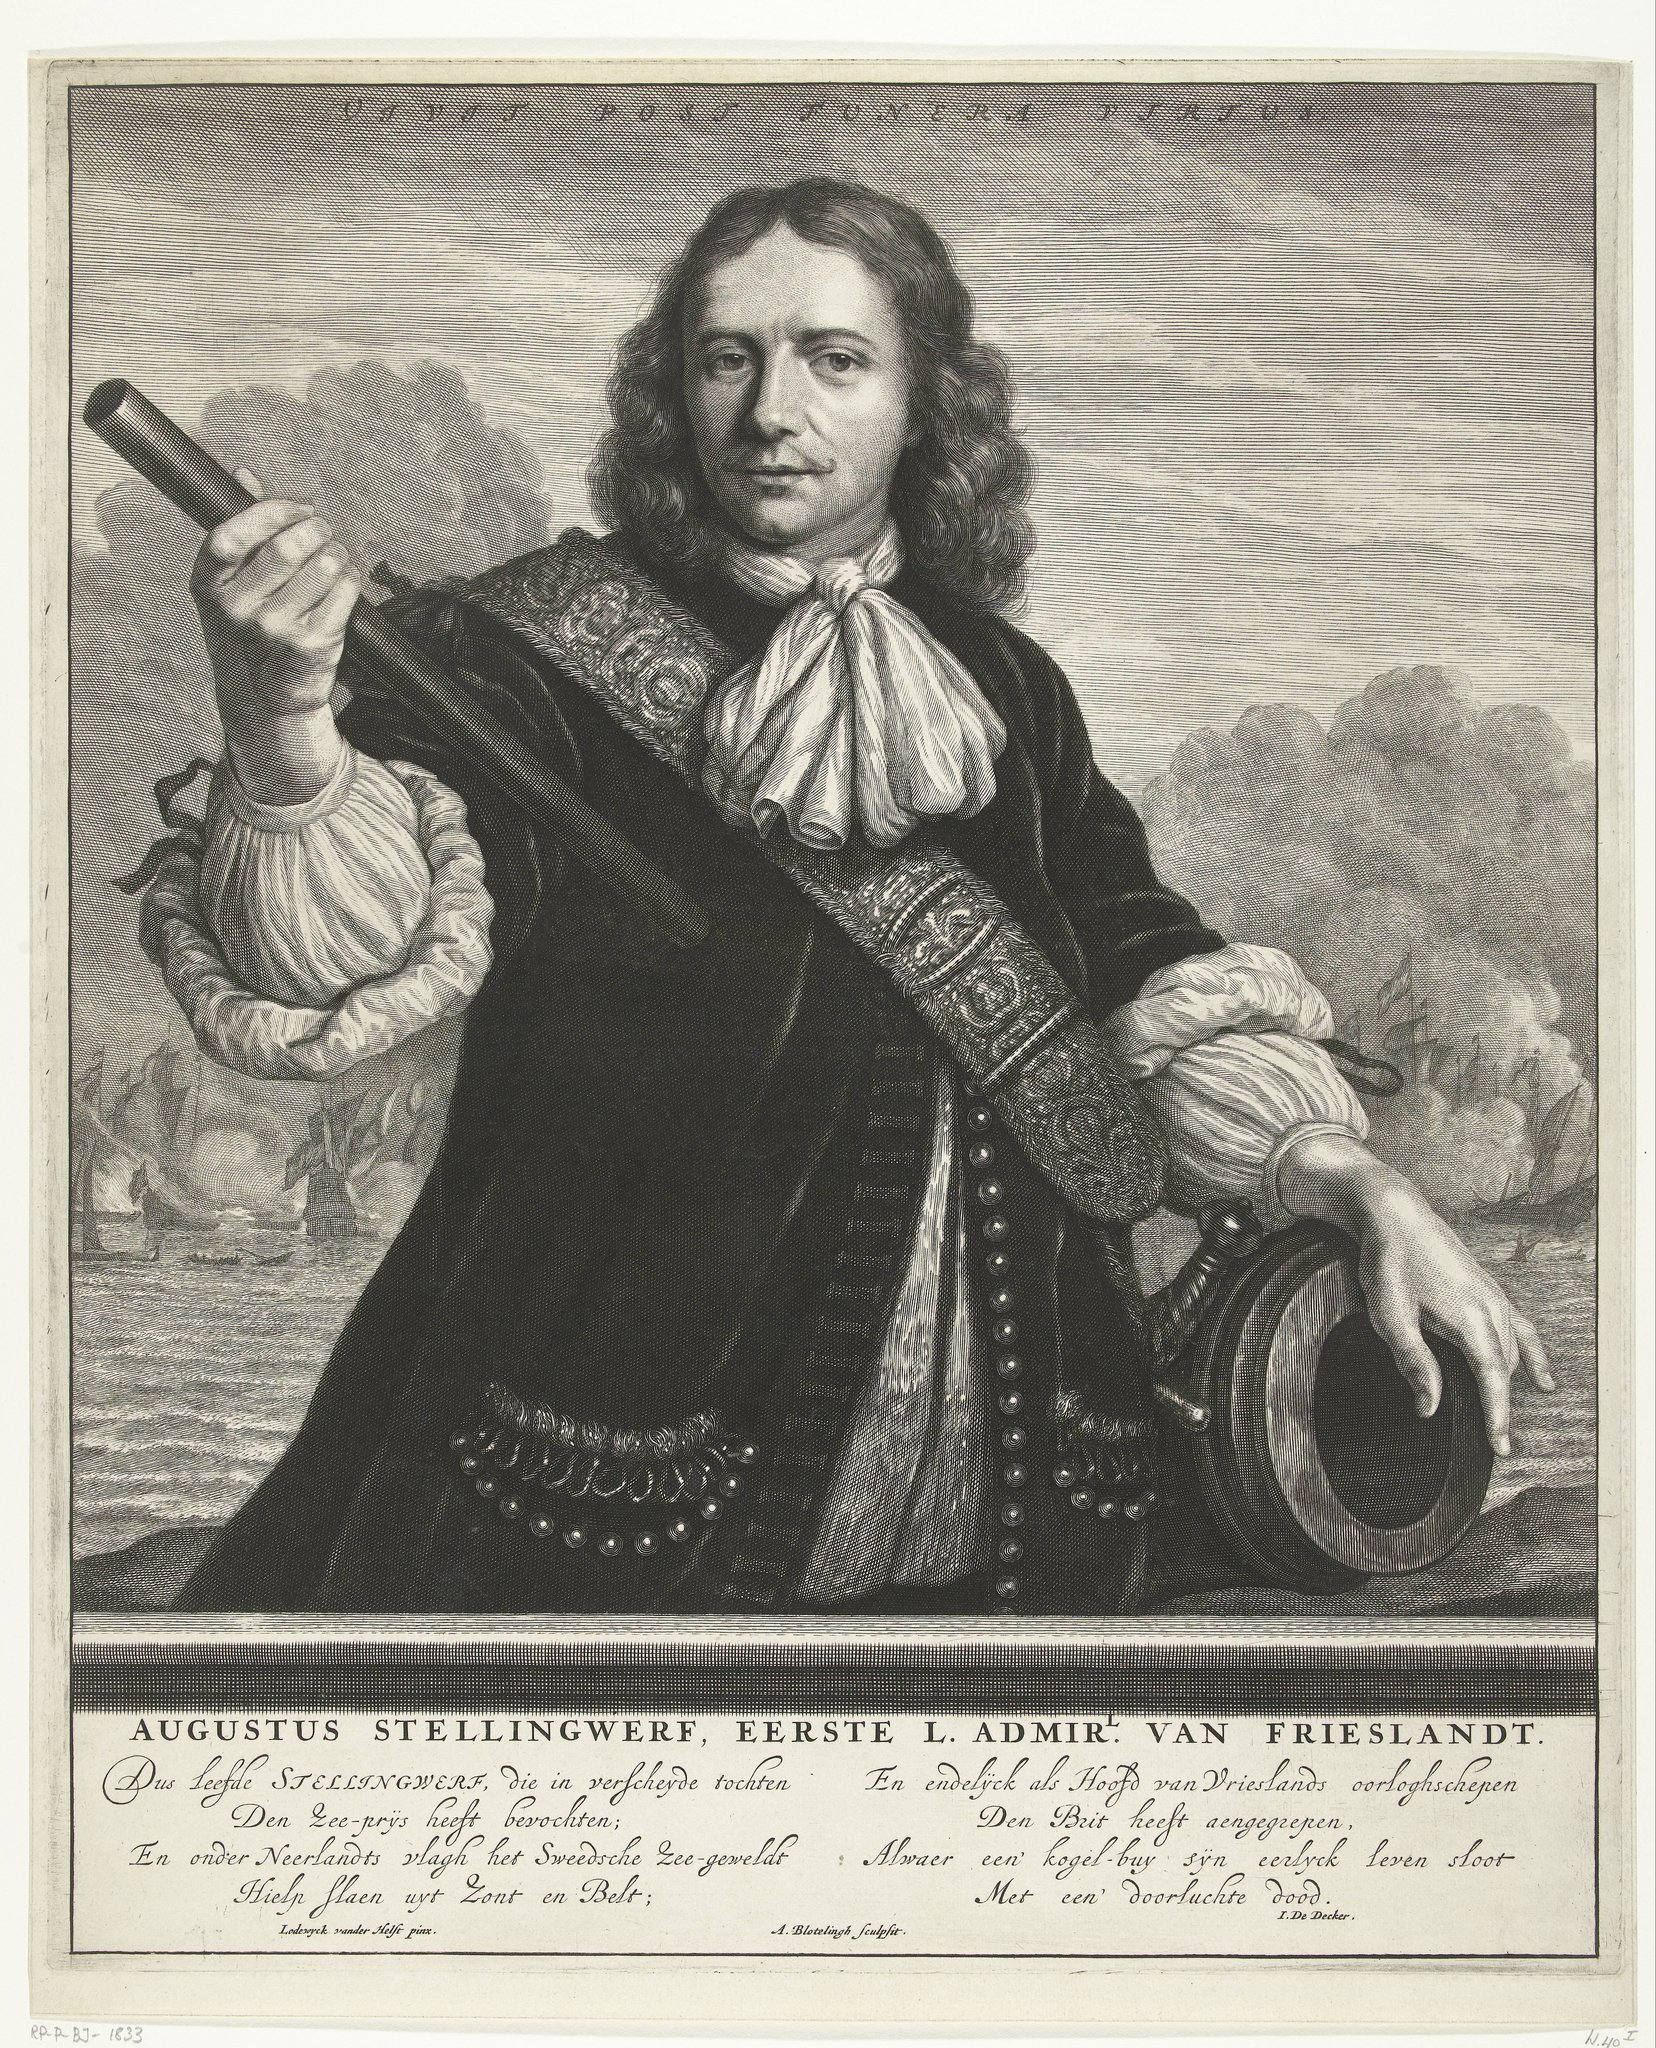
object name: print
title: Augustus Stellingwerf, eerste L. Admiral. van Frieslandt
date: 1670-1690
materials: paper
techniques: engraving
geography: amsterdam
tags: lowestoft, admiraal, aucke stellingwerff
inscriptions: collector's mark: Lugt 12, collector's mark: Lugt 2228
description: Portret van de Friese admiraal Aucke Stellingwerff voor een kanon met het commandostaf in zijn hand. Op de achtergrond is een zeeslag bezig. Boven het portret het motto: Vivit post funera virtus. Onder het portret een Nederlands vers over Stellingwerfs overwinningen tegen Zweden en Engeland en over zijn dood.